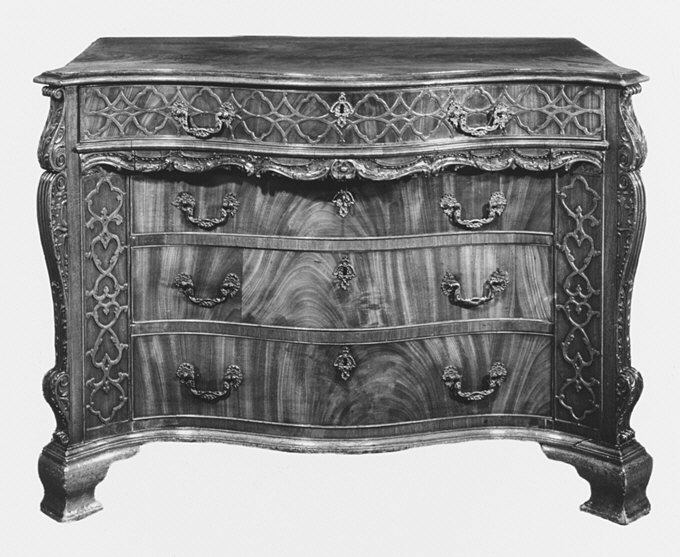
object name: commode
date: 1755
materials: gilt bronze, wood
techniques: veneering